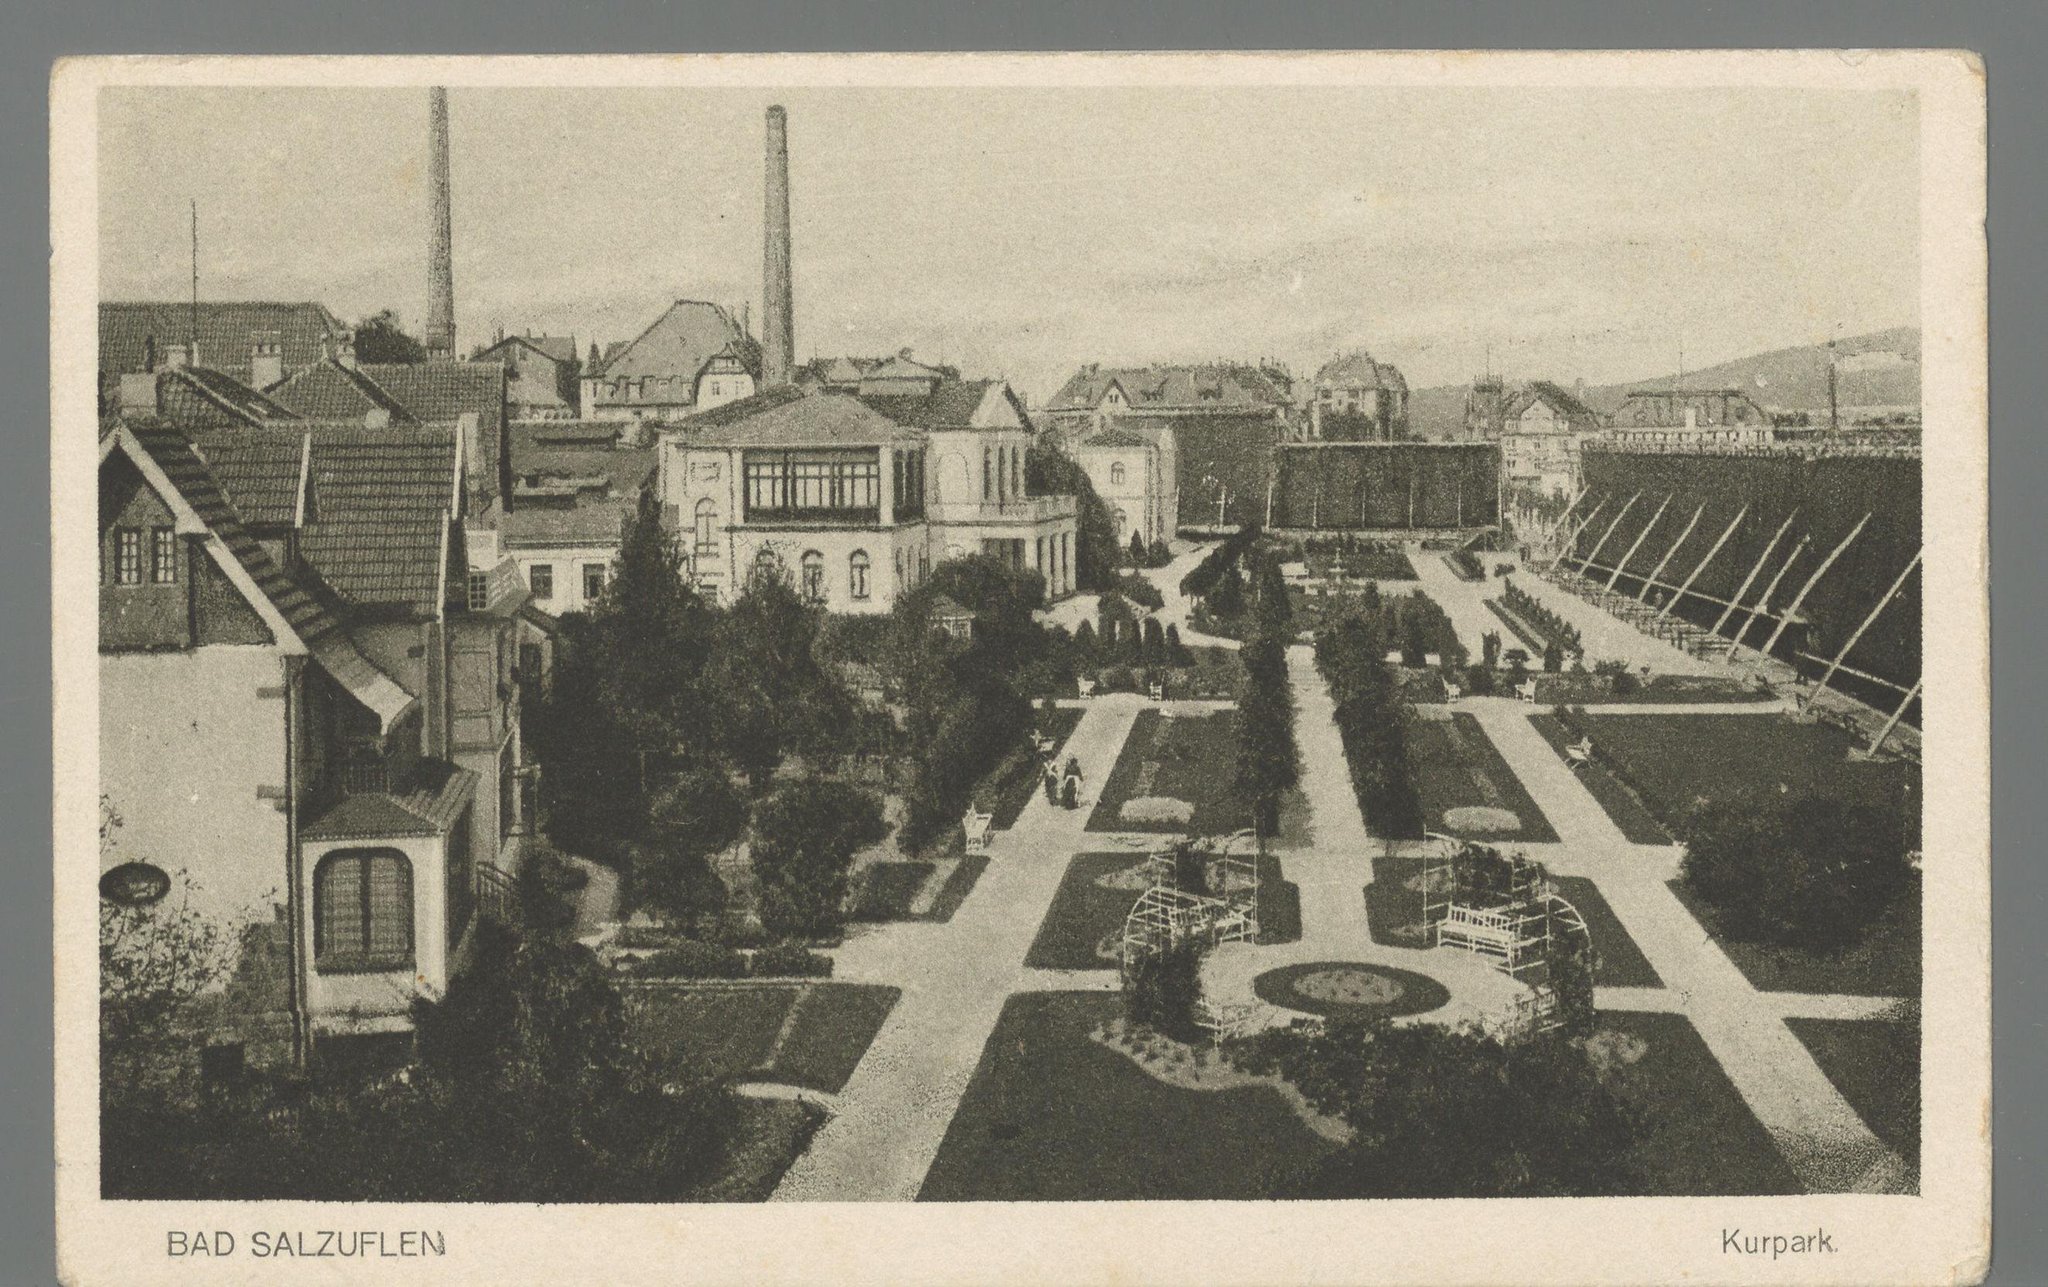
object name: ansichtkaart, prentbriefkaart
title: Bad Salzuflen. Kurpark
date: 1905-1930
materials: cardboard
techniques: rotogravure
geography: dortmund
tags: watering-place, spa